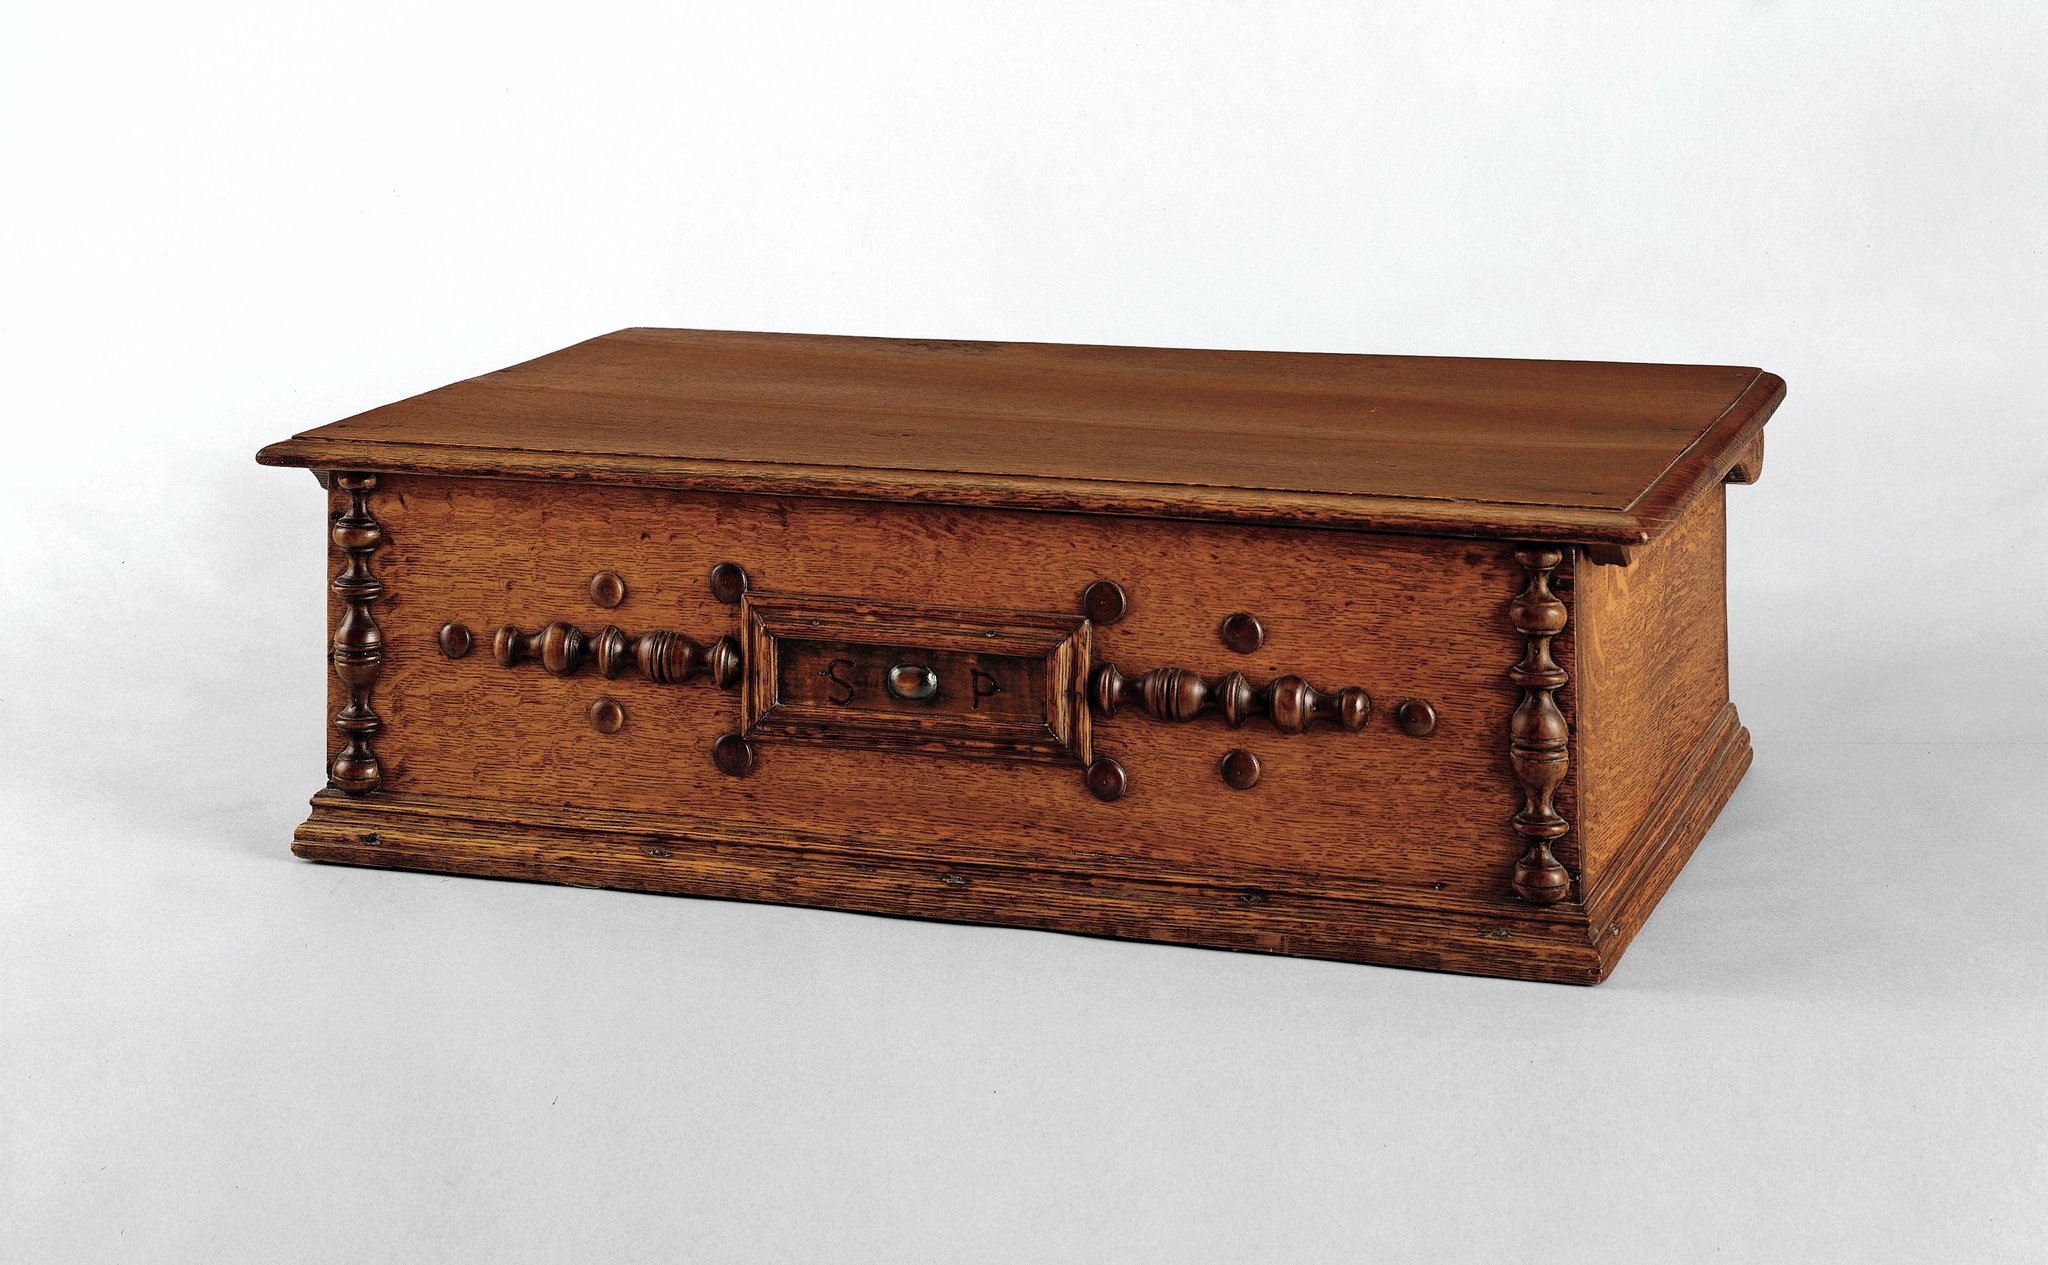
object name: box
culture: american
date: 1680-1700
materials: wood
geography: united states